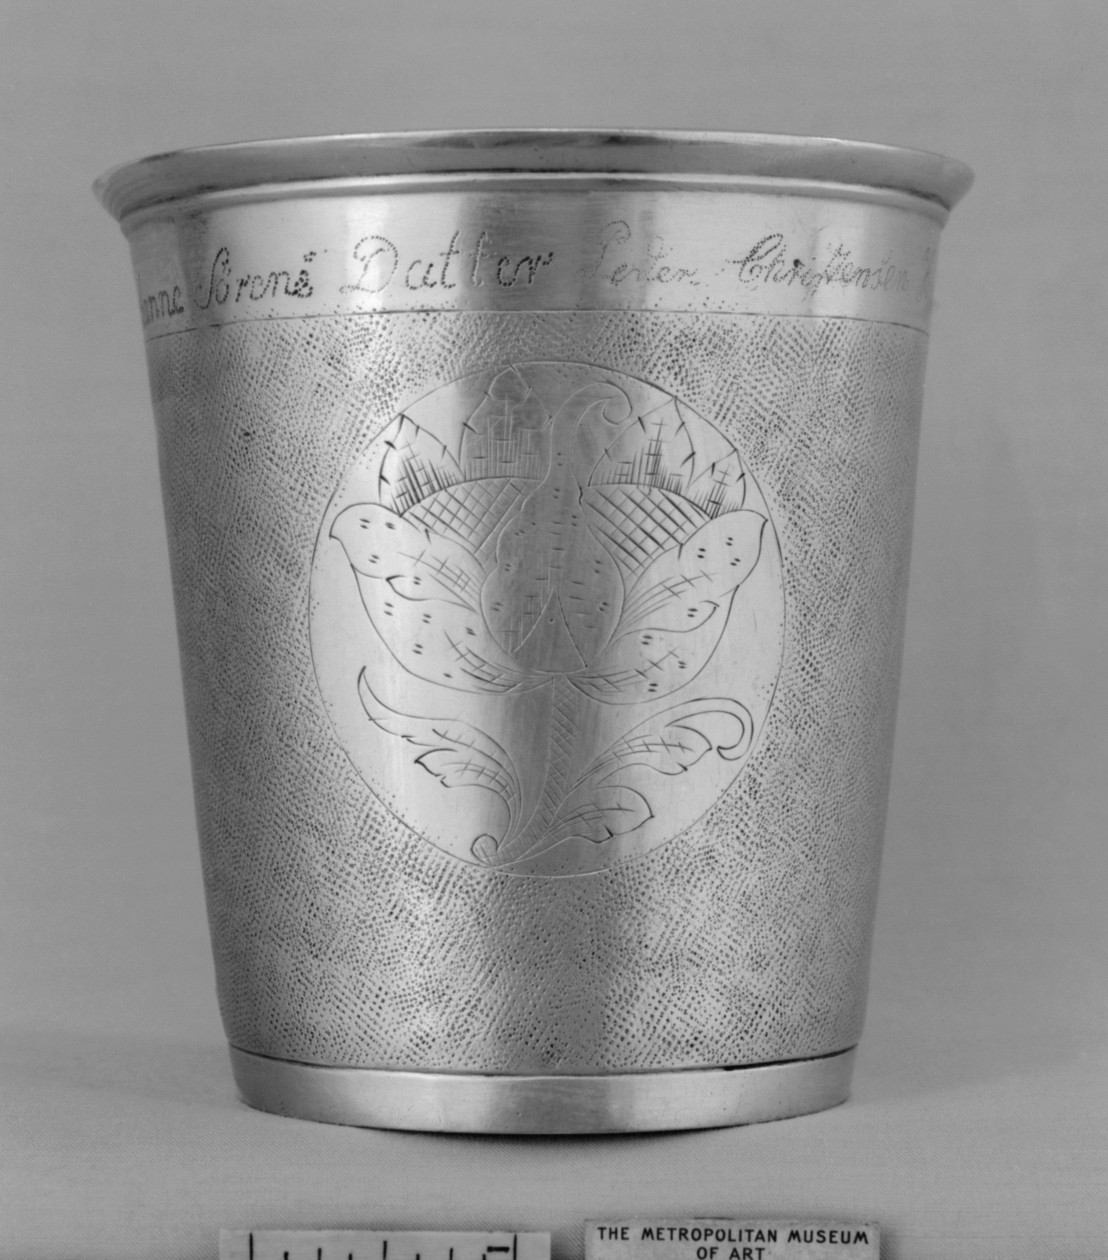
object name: beaker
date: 1701-1800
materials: silver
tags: flowers